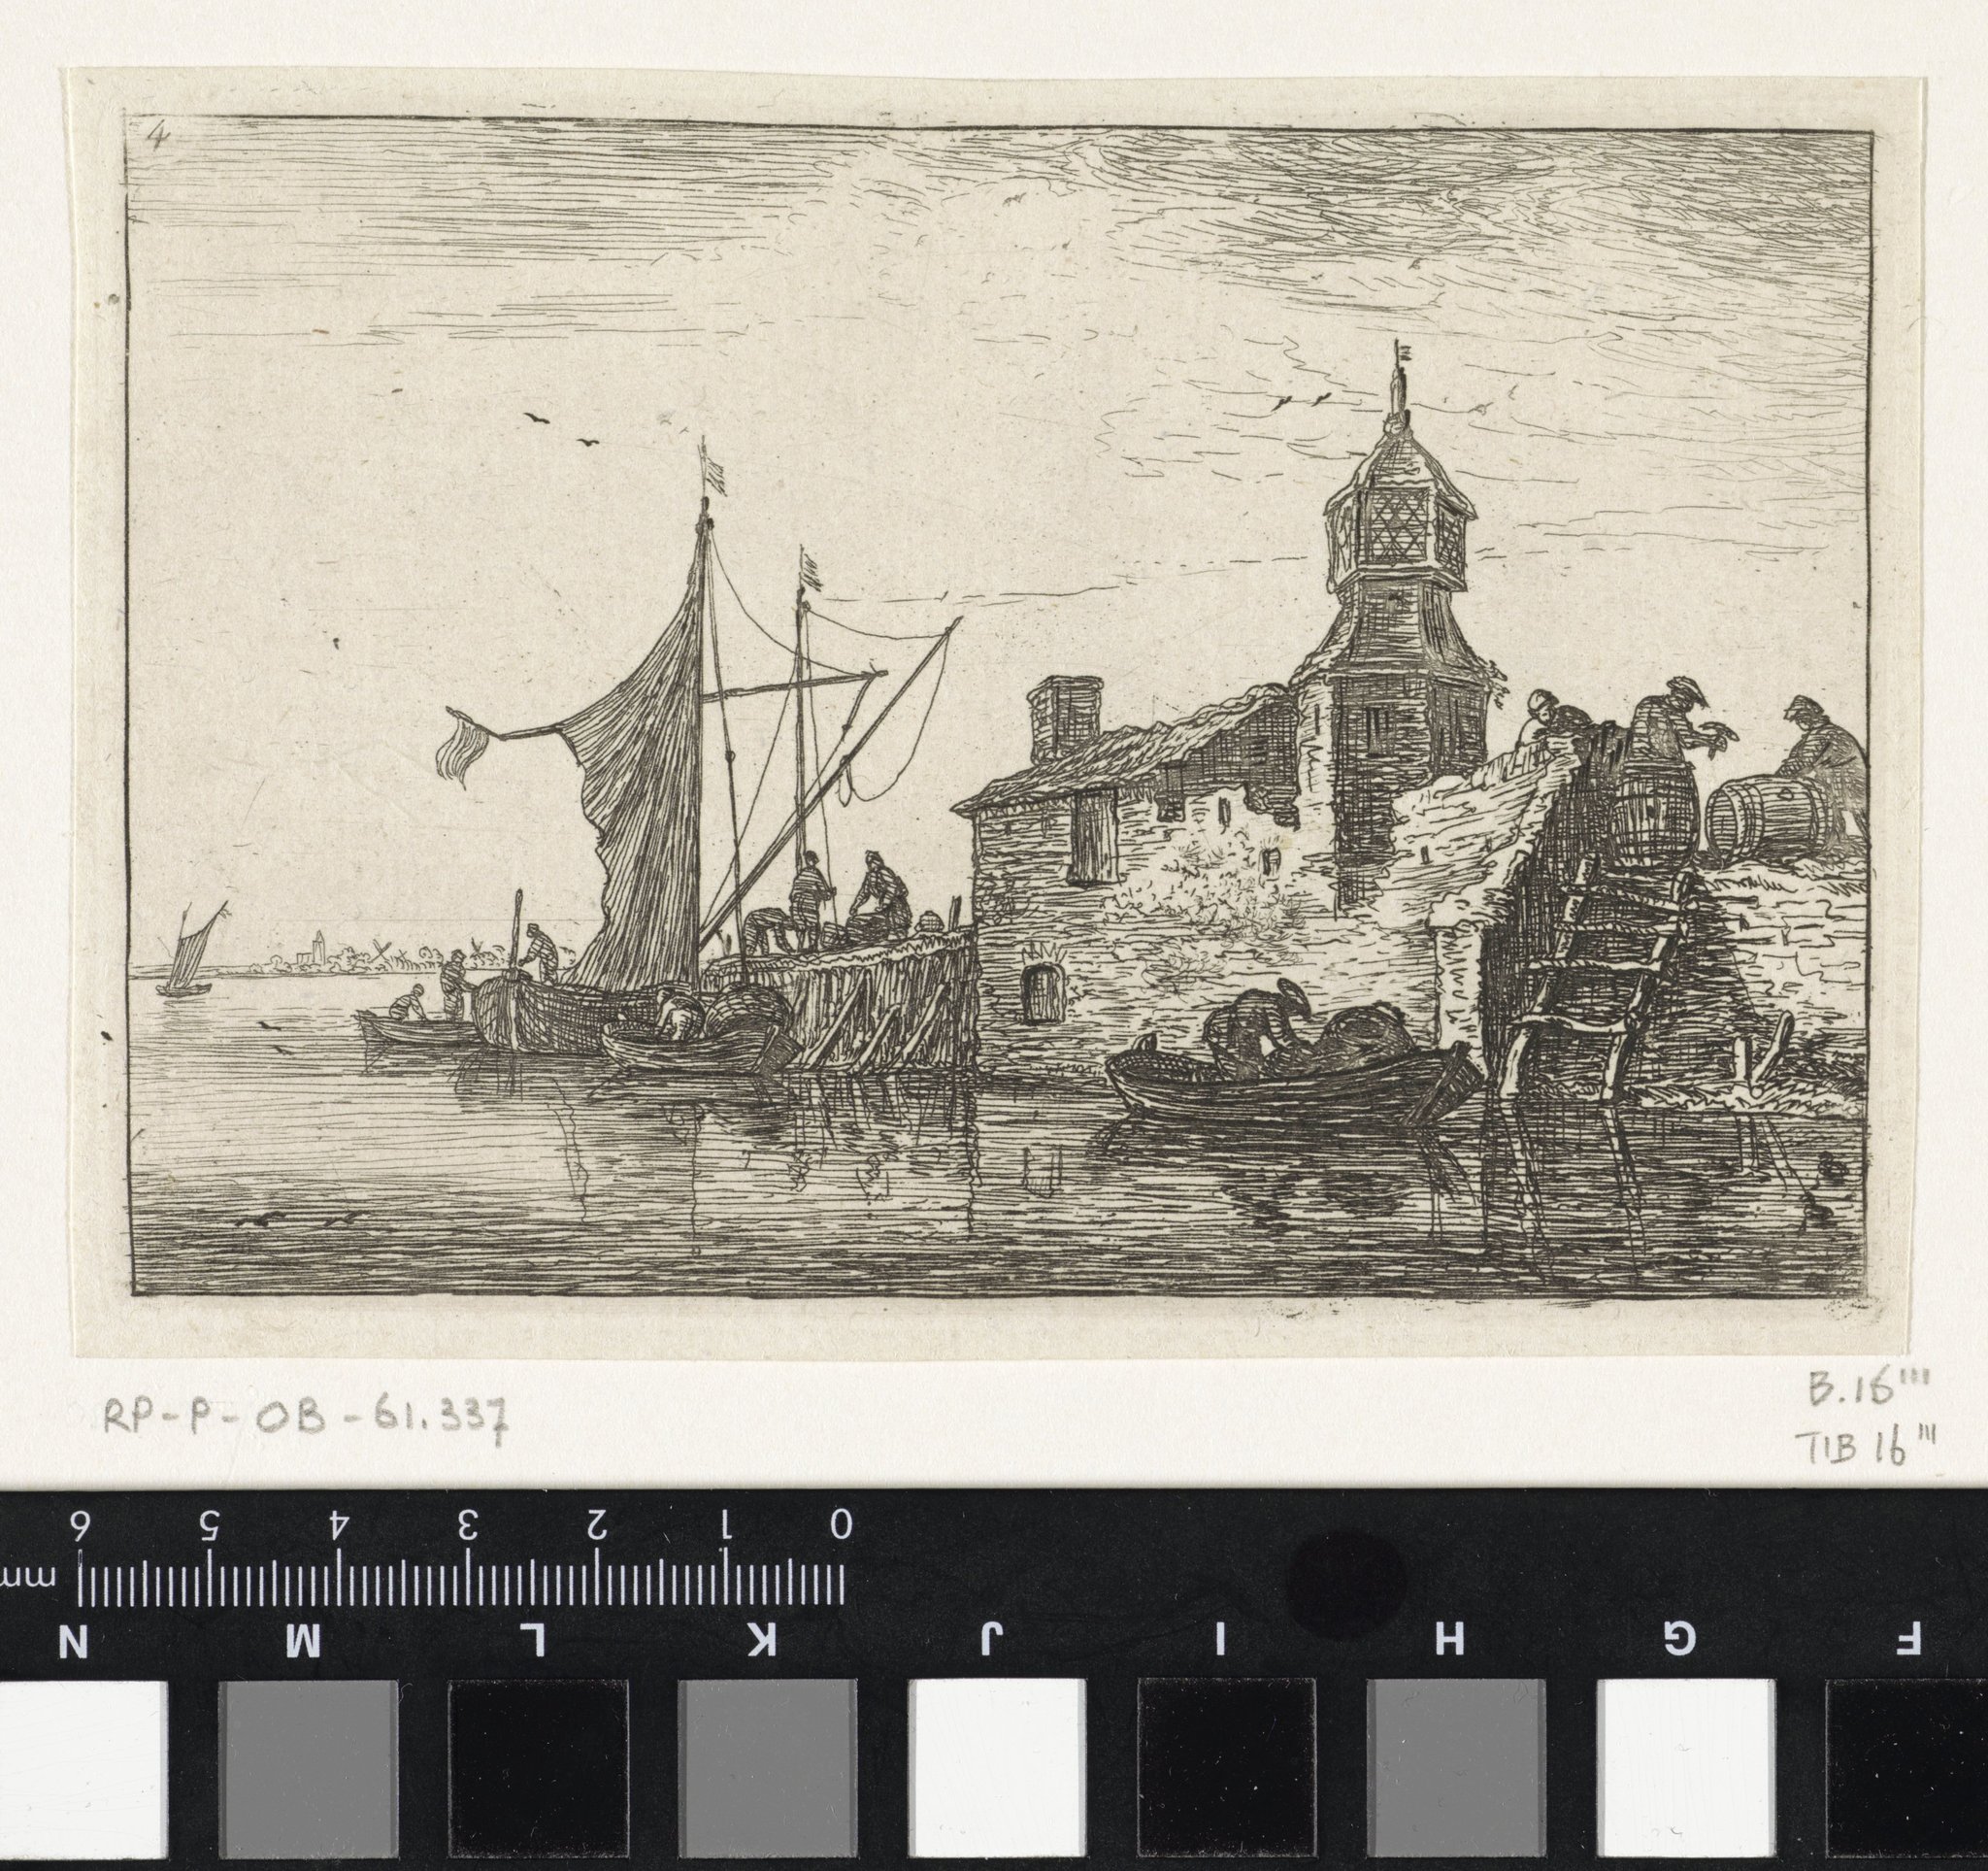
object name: print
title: Aanlegplaats bij een gebouw met een toren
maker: anthonie waterloo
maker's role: draughtsman, painter, print maker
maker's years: 1609-1690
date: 1630-1663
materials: paper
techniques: etching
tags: sailing-ship, sailing-boat, landscapes with waters, waterscapes, seascapes (in the temperate zone), rowing-boat, canoe, etc., ladder, pier, quay, wharf, tower (of house or building), labour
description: Aan het water staat een gebouw met een kleine toren. Rechts zijn mannen met tonnen in de weer bij een ladder, die naar een boot in het water leidt. Links van het gebouw is een aanlegsteiger met verschillende, bemande boten te zien.